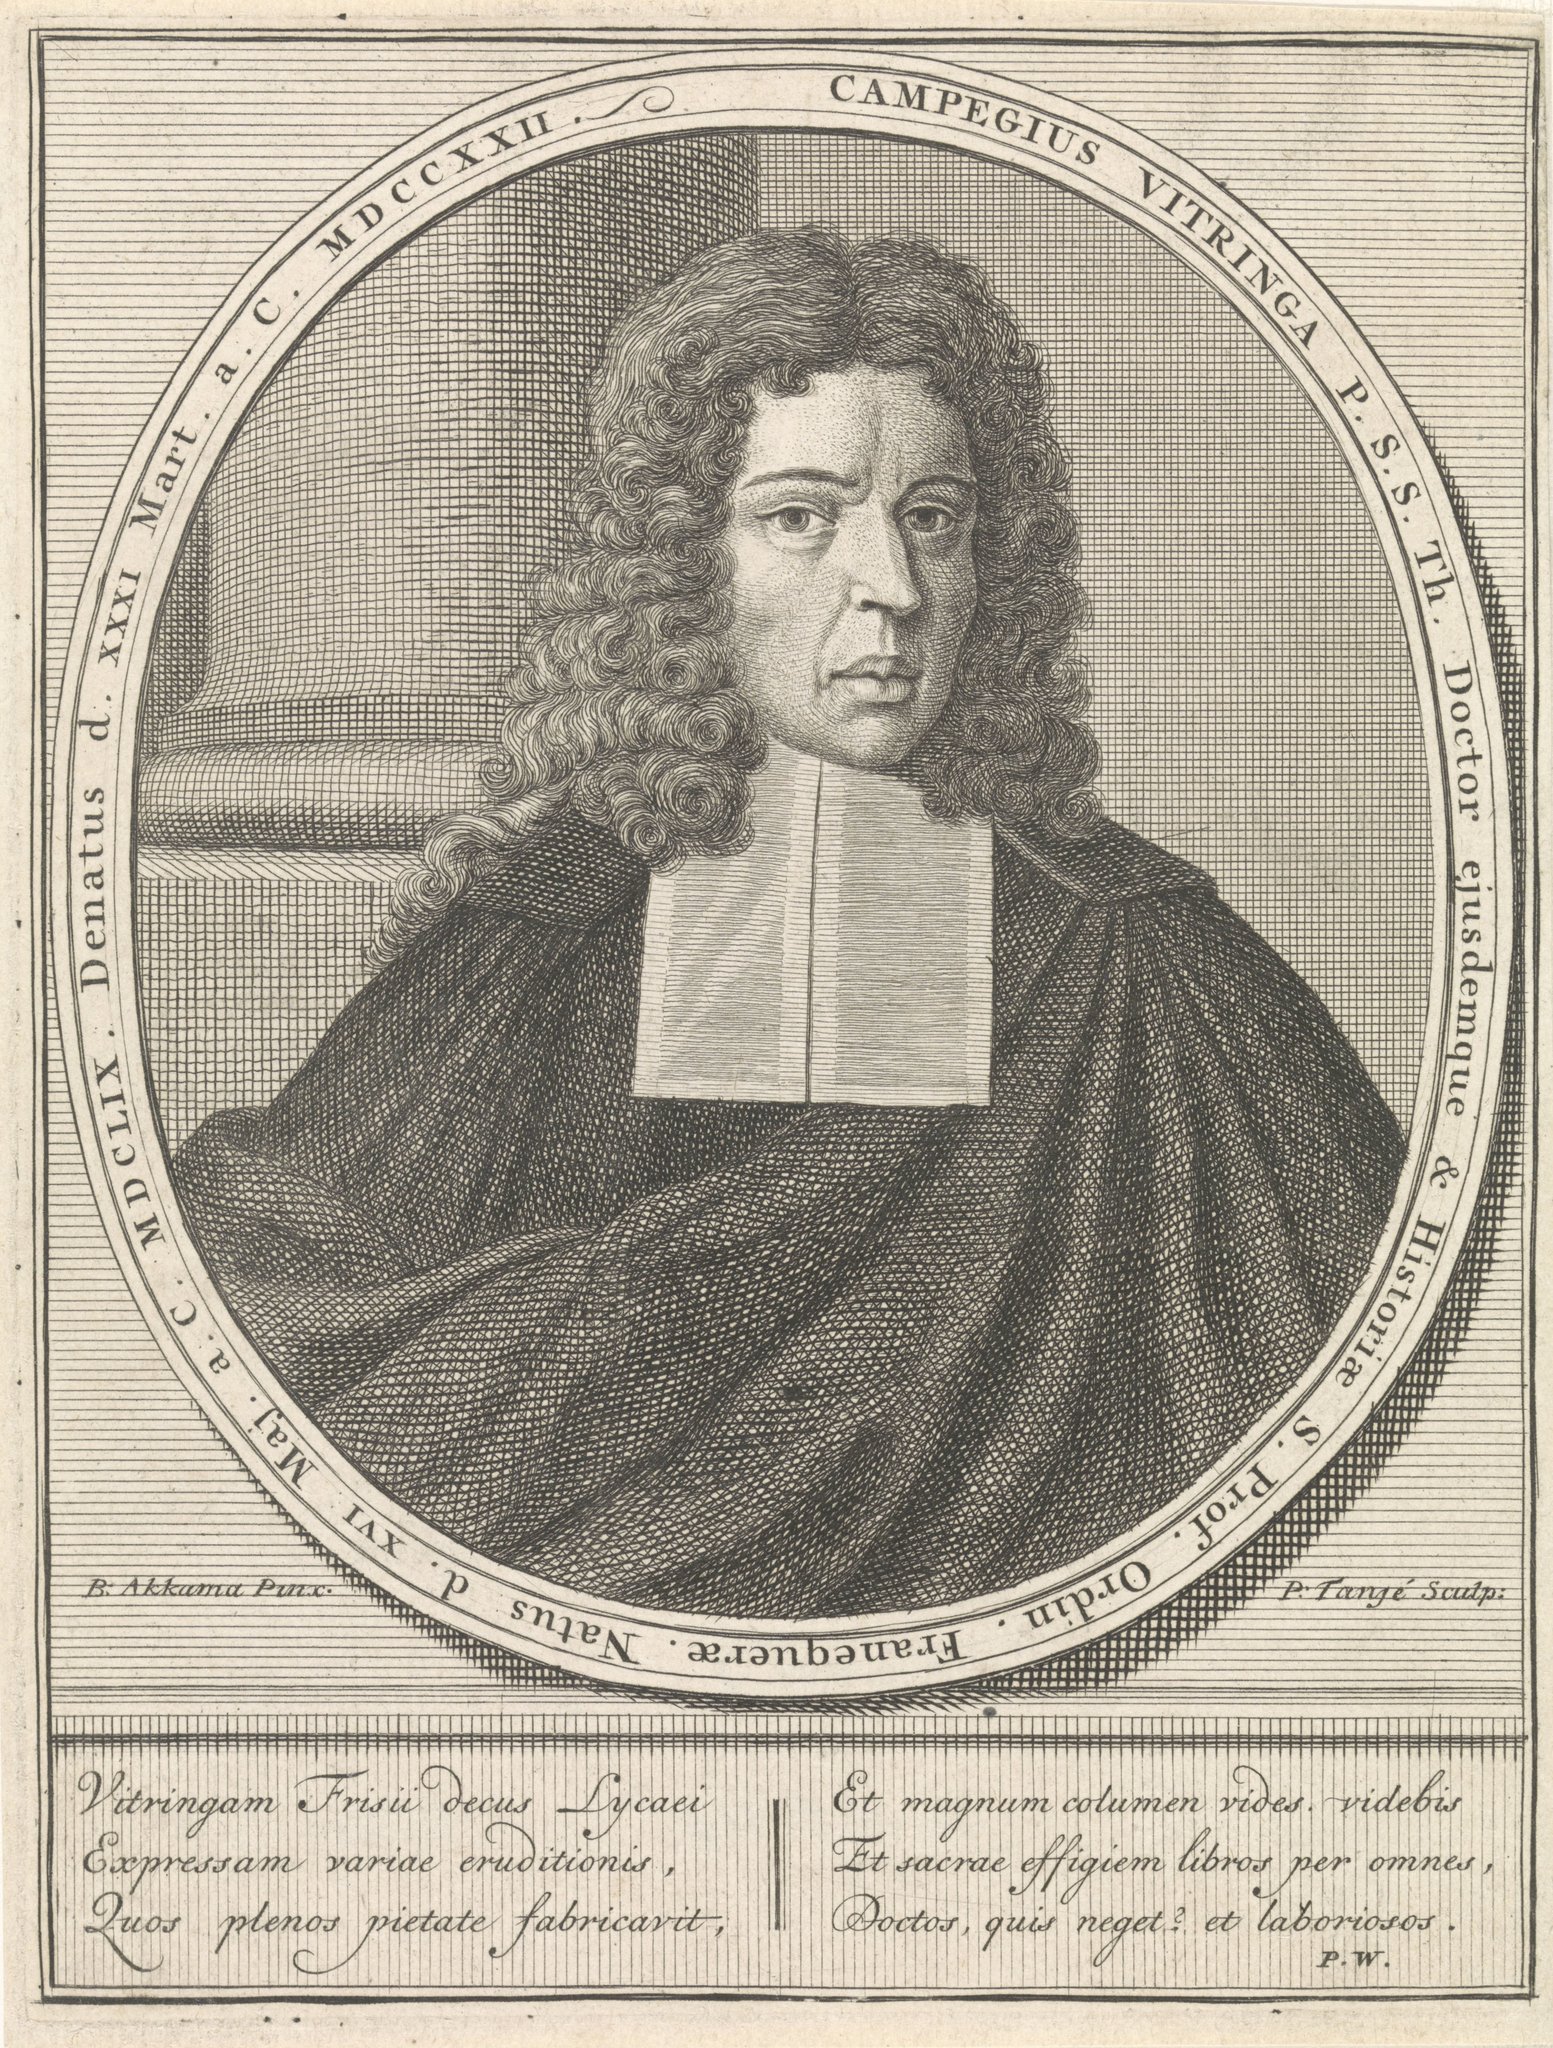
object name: print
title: Portret van Campegius Vitringa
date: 1716-1761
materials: paper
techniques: engraving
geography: amsterdam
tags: leeuwarden, theoloog, campegius vitringa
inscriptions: collector's mark: Lugt 2228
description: Campegius Vitringa, theoloog en hoogleraar te Franeker. Onderaan in de marge een zesregelig vers in het Latijn.